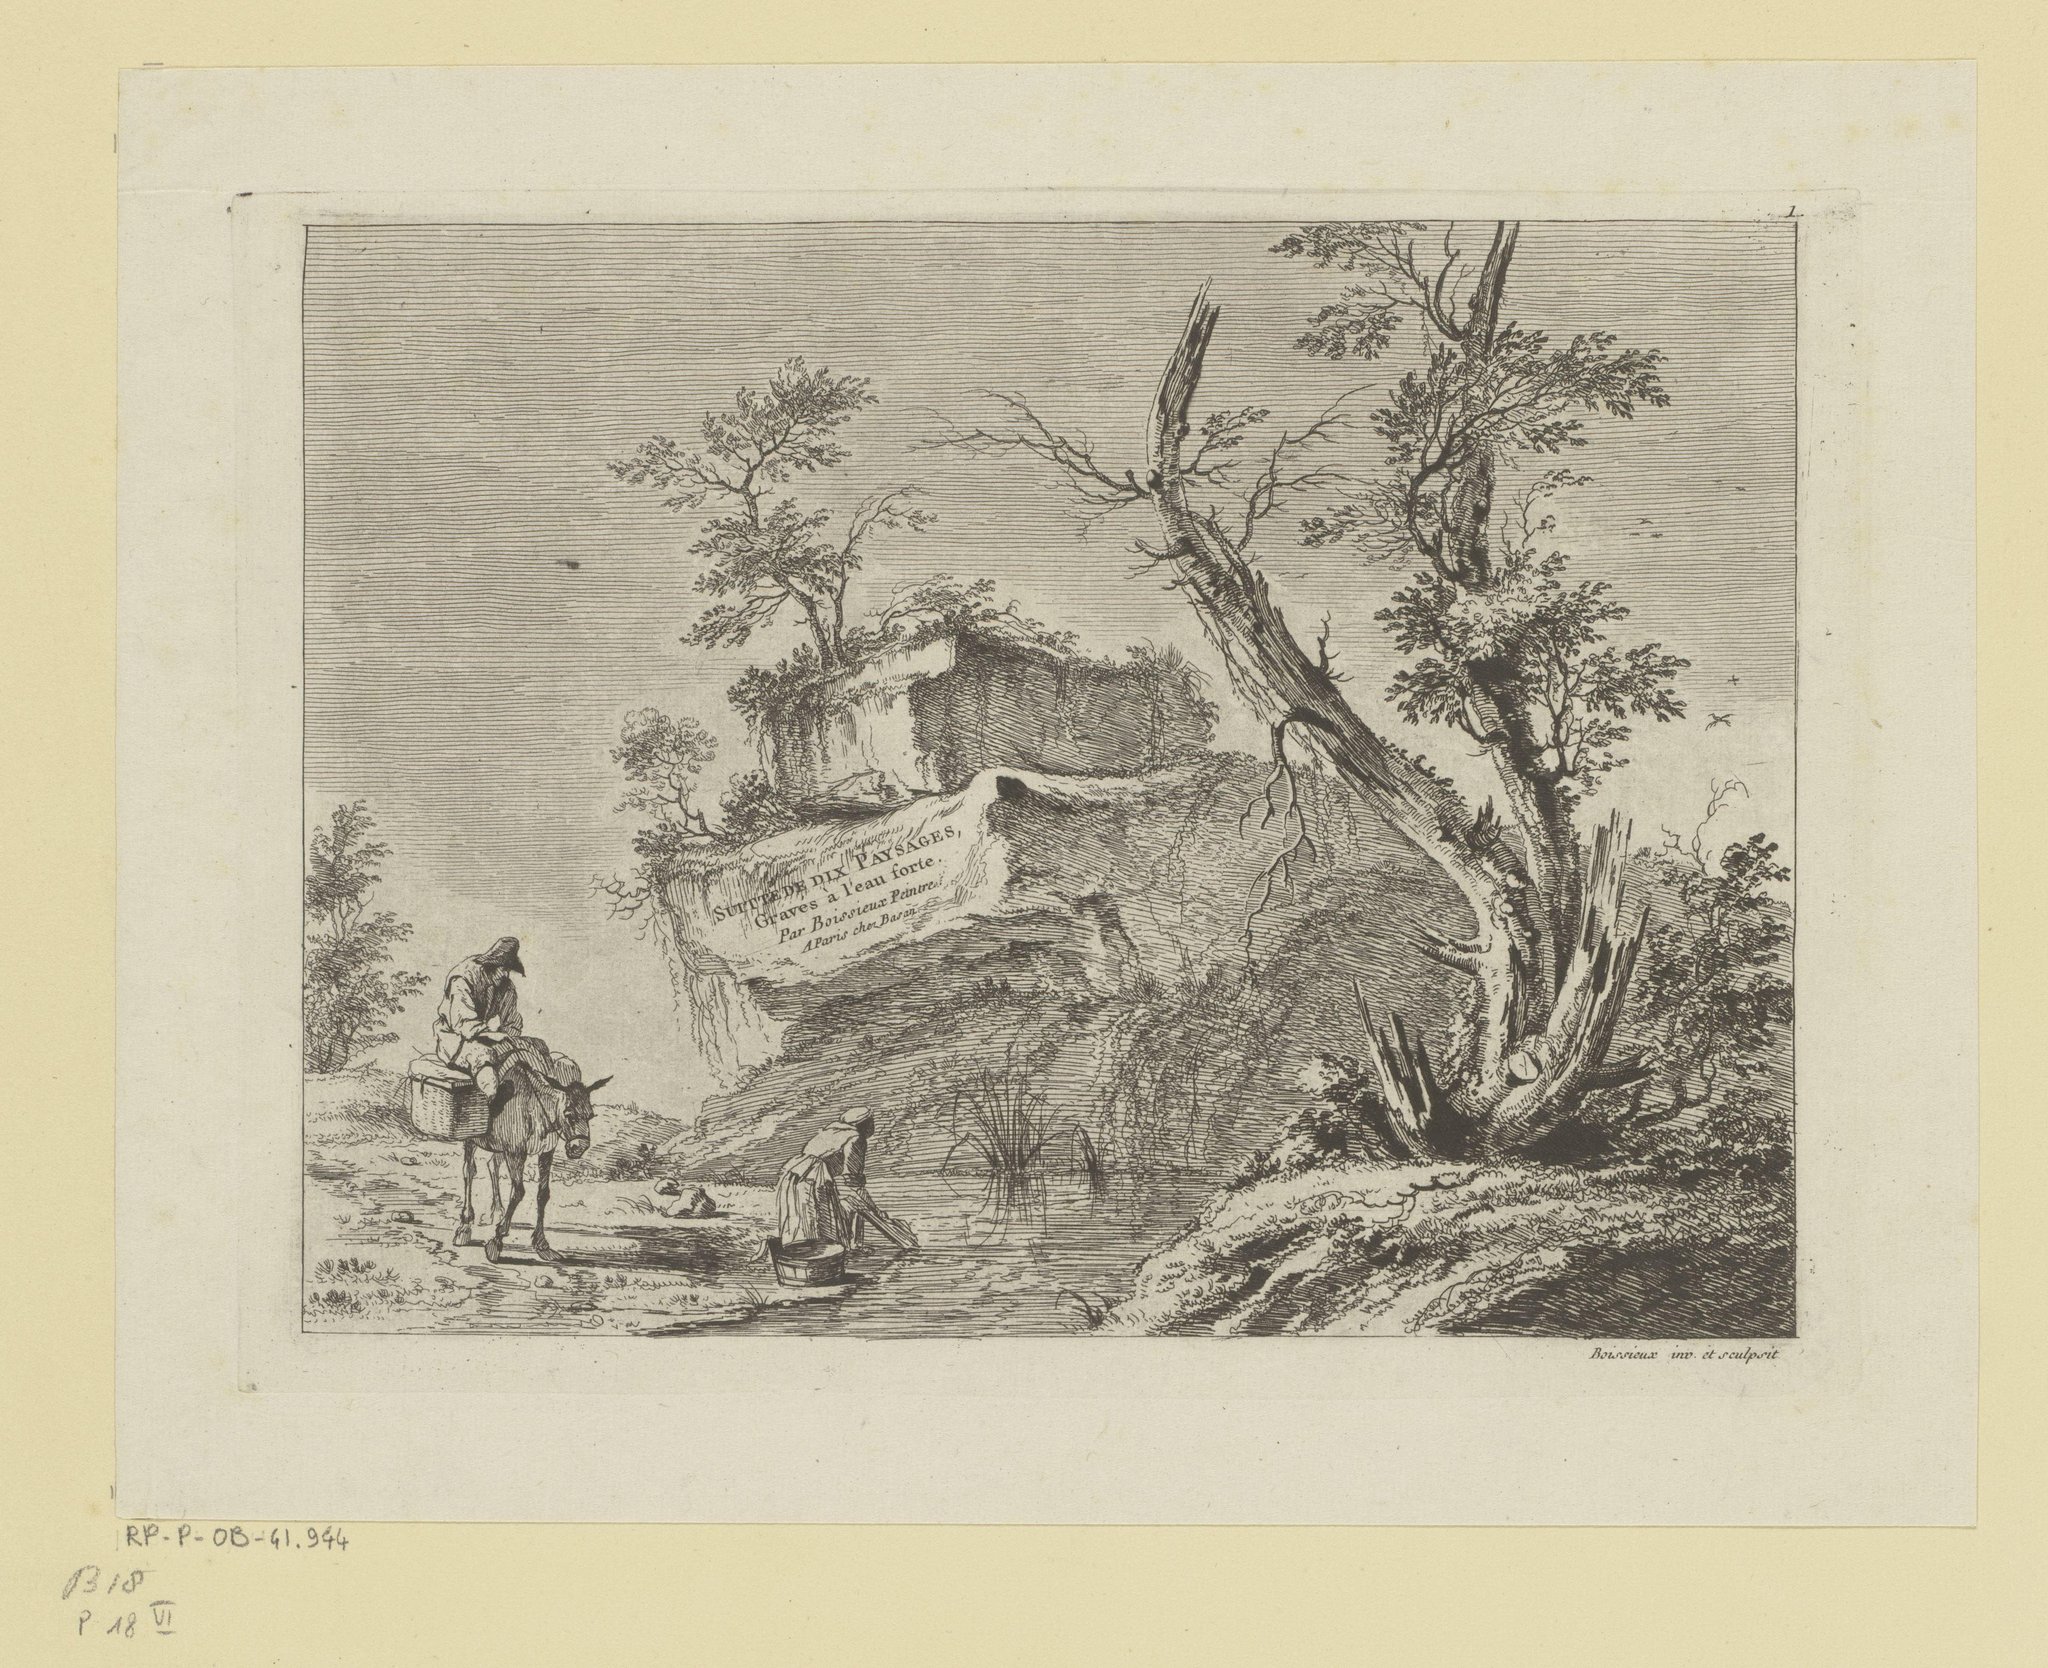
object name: print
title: Titelprent met twee figuren bij een rots in het water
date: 1763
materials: paper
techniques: etching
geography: france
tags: landscapes (+ landscape with figures, staffage), rocks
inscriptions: collector's mark: Lugt 12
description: Titelprent voor een tiendelige serie met landschappen, uitgegeven door Basan te Parijs in 1763.